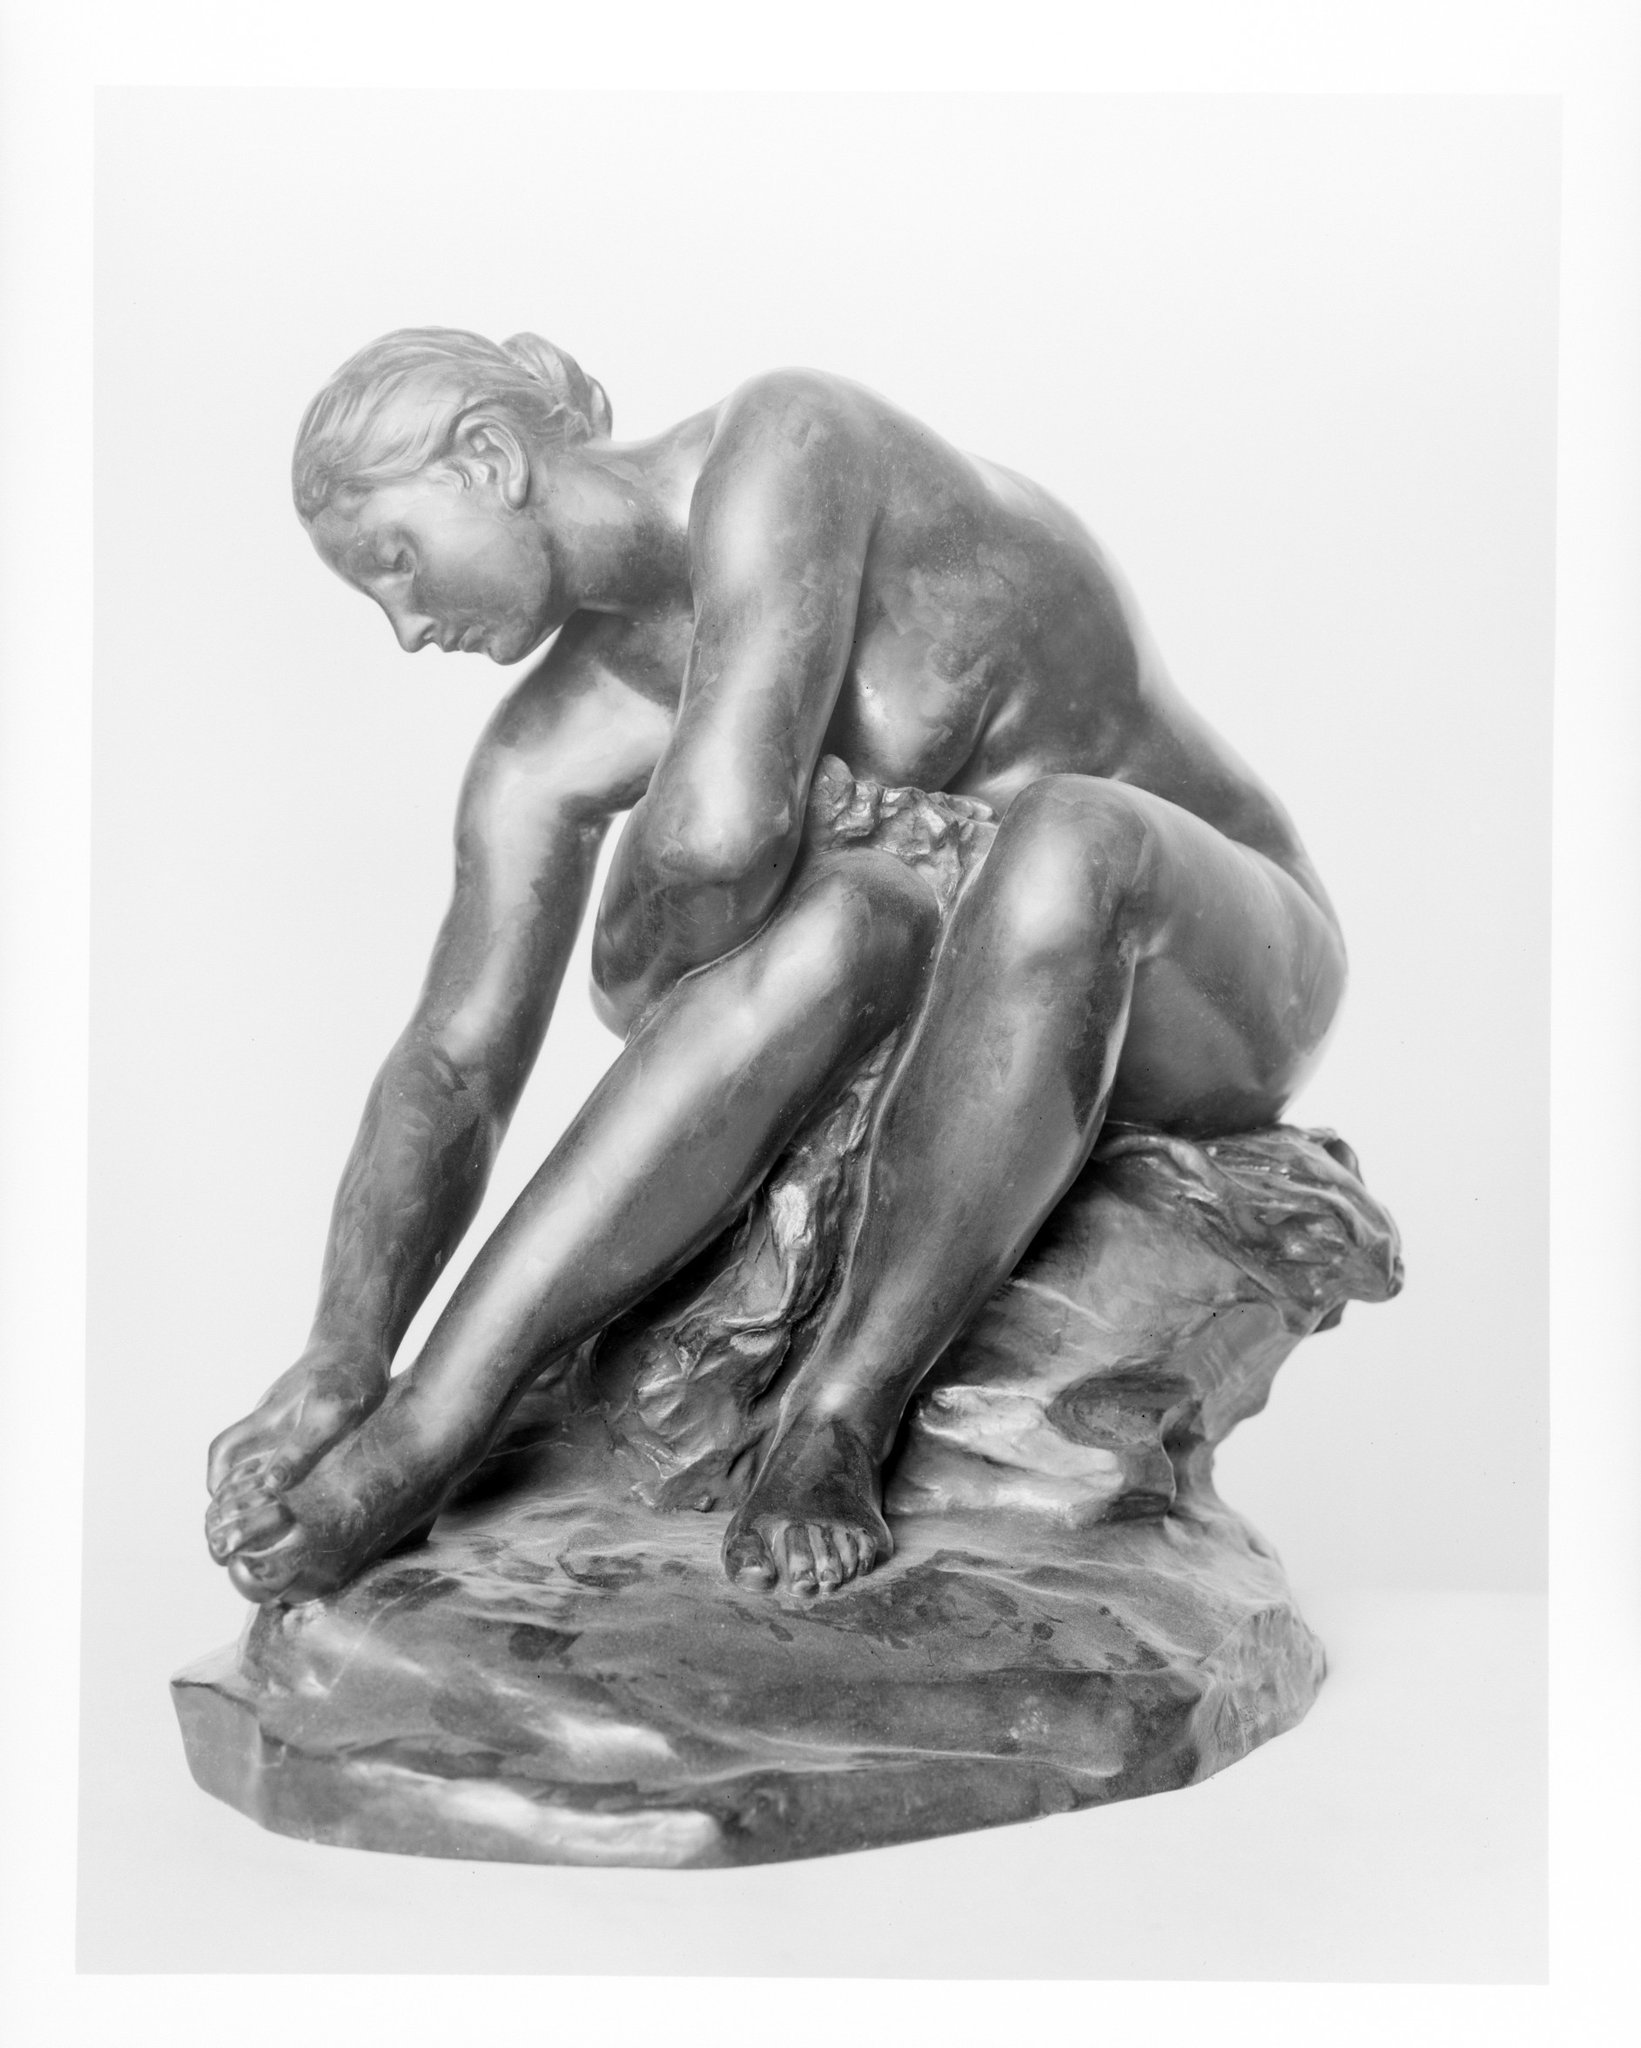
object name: statuette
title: Woman Bathing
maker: aimé-jules dalou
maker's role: artist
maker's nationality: french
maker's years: 1838-1902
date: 1801-2000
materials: bronze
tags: female nudes,bathing